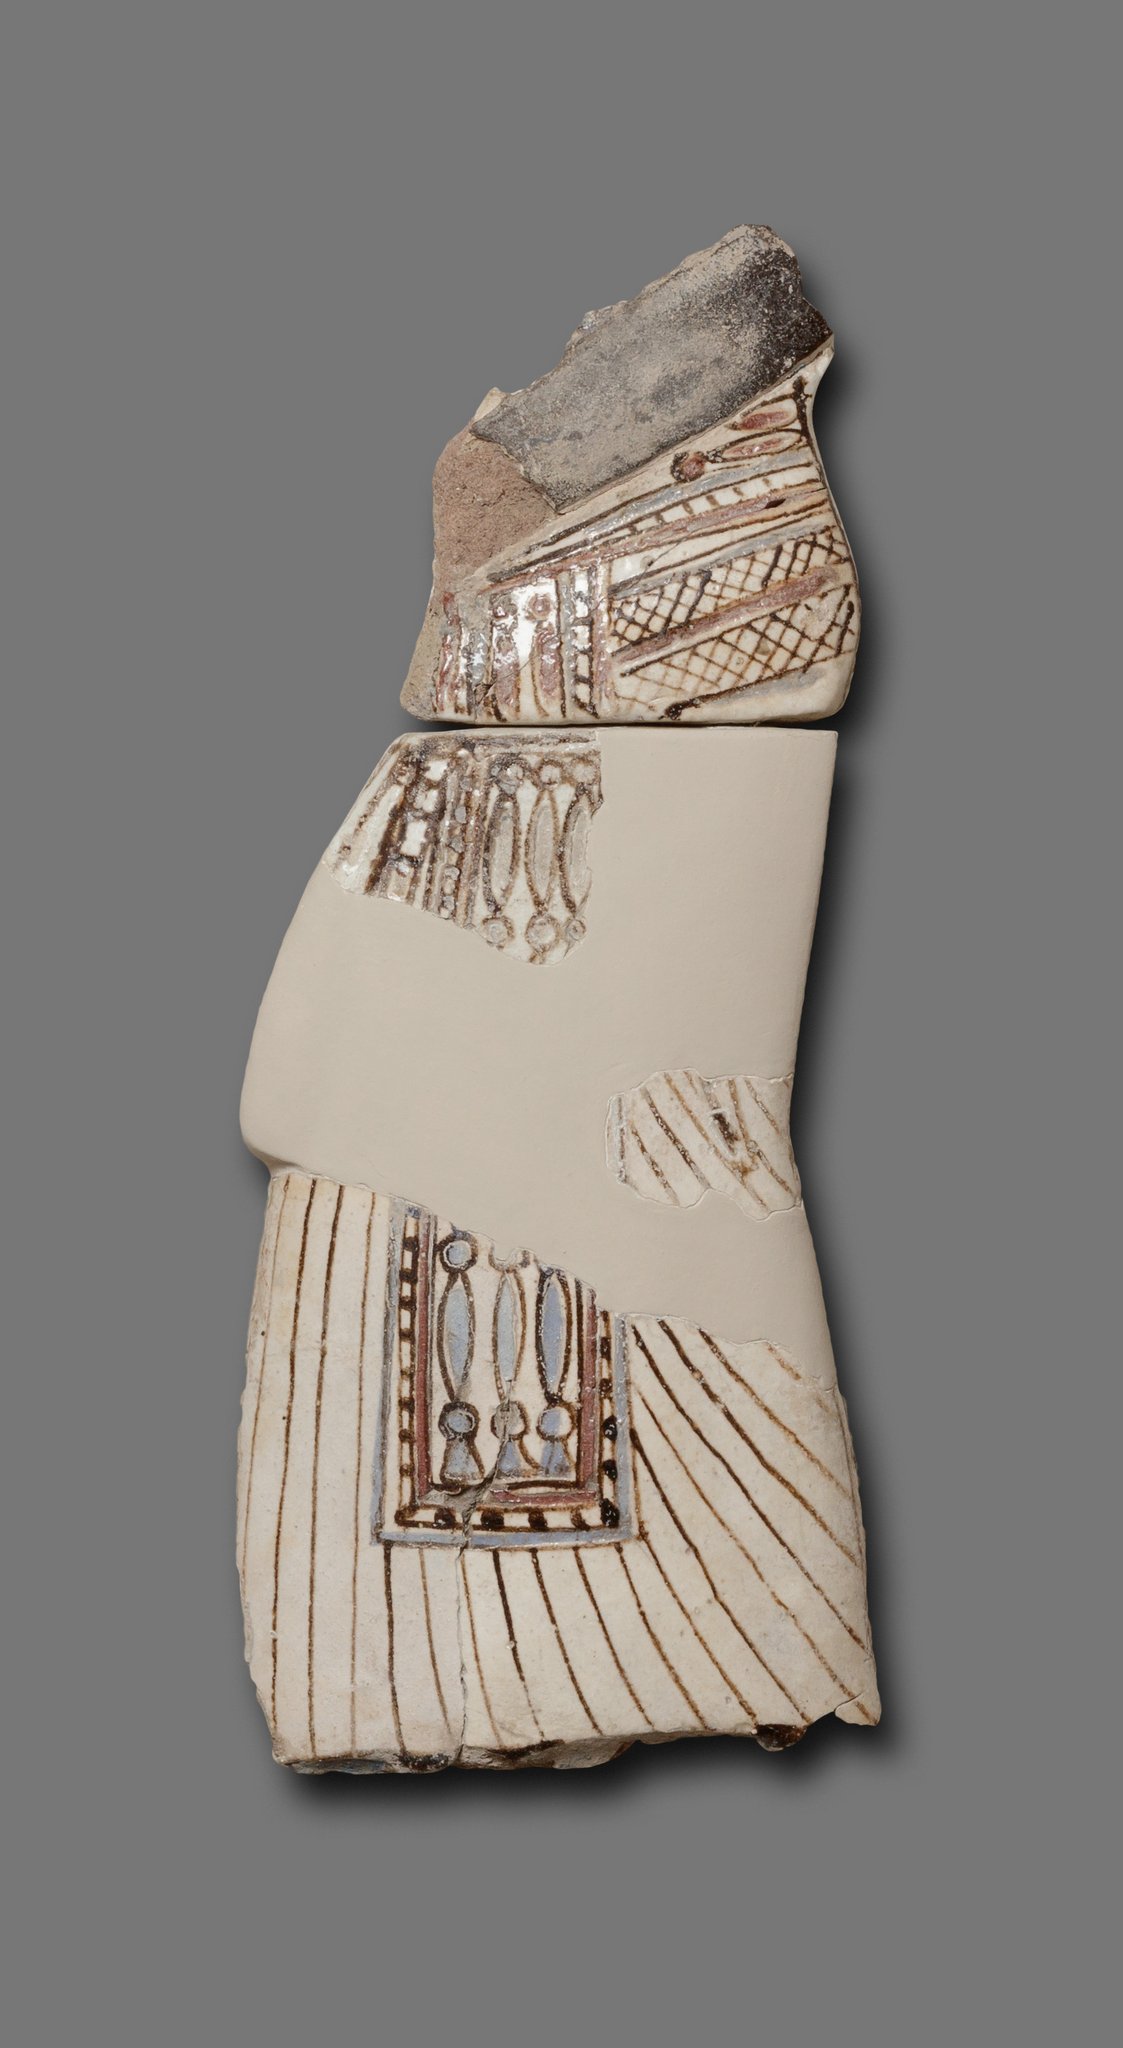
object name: tile inlay, palace of ramesses ii, foreigner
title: Tile Inlay of a Torso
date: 1279-1213 BCE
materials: faience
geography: egypt